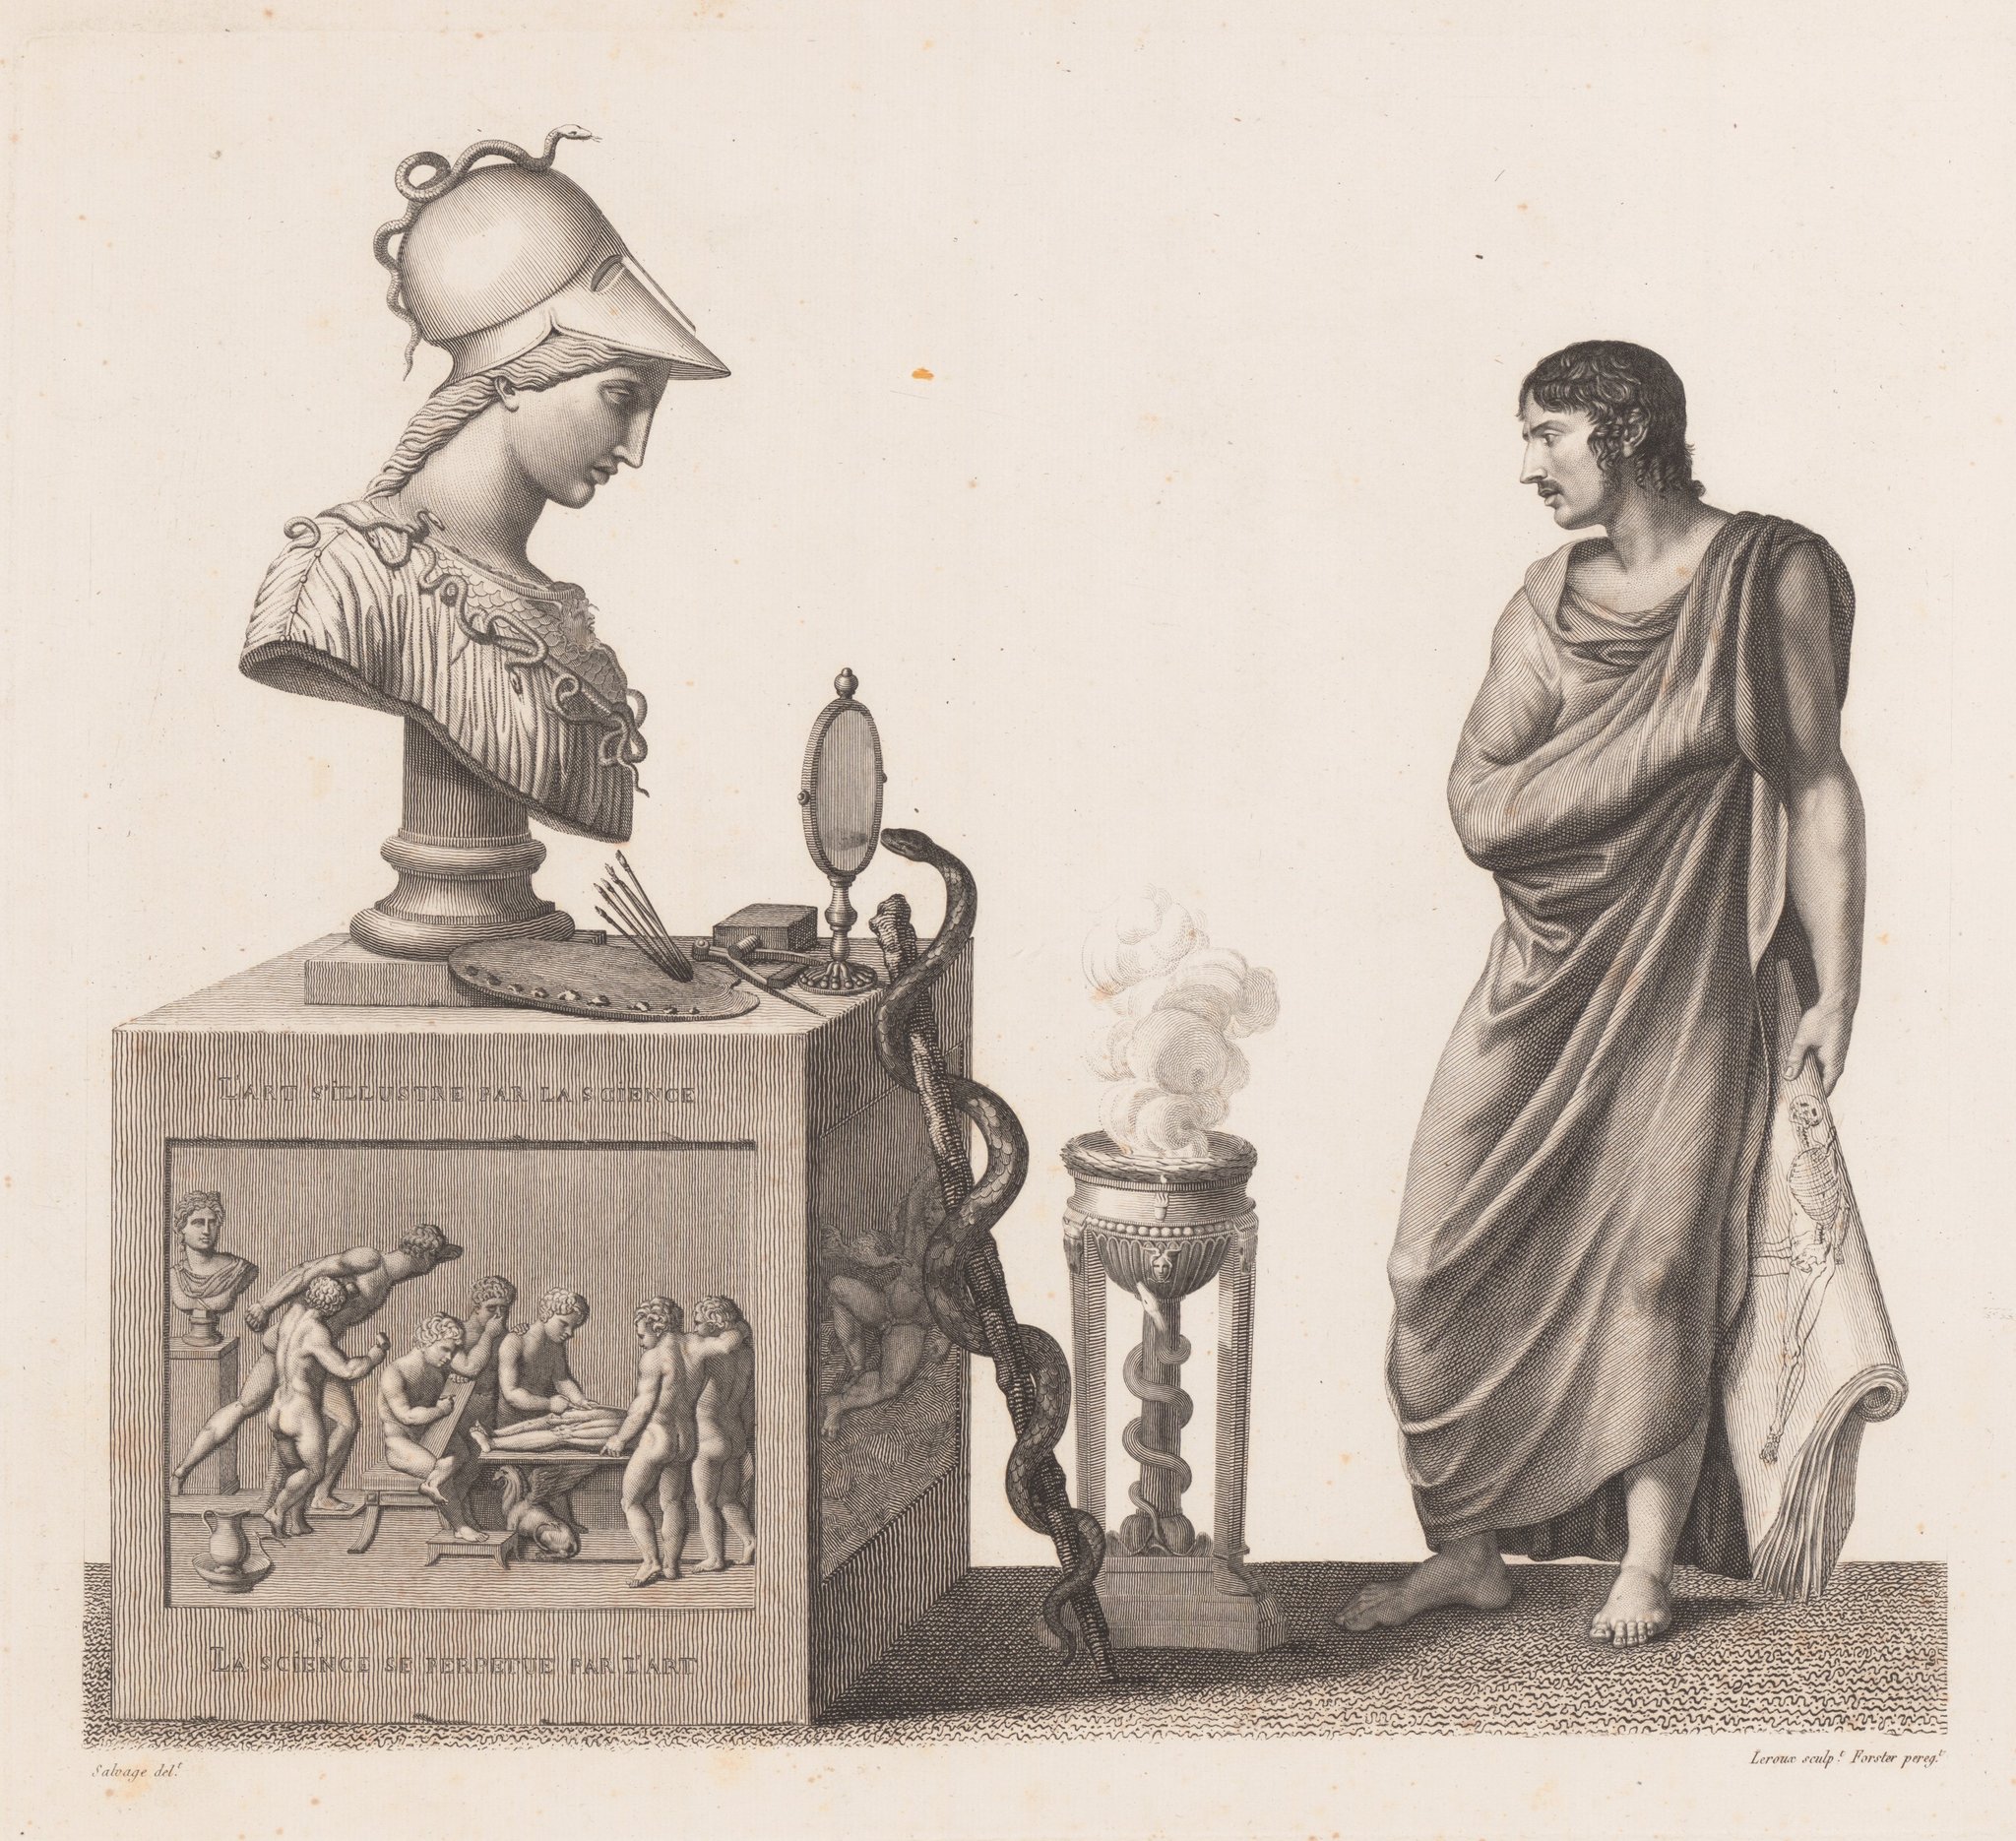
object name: book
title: Anatomie du gladiateur combattant applicable aux beaux arts, ou Traité des os, des muscles, du mécanisme de mouvemens, de proportions et des caractères du corps humain (Anatomy of the Fighting Gladiator), Paris (Salvage), 1812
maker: jean-galbert salvage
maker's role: artist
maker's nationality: french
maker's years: 1770-1813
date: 1812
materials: board, gold, ink, leather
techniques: bookbinding, engraving, printing, stamping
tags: sculpture,men,male nudes,snakes,palettes